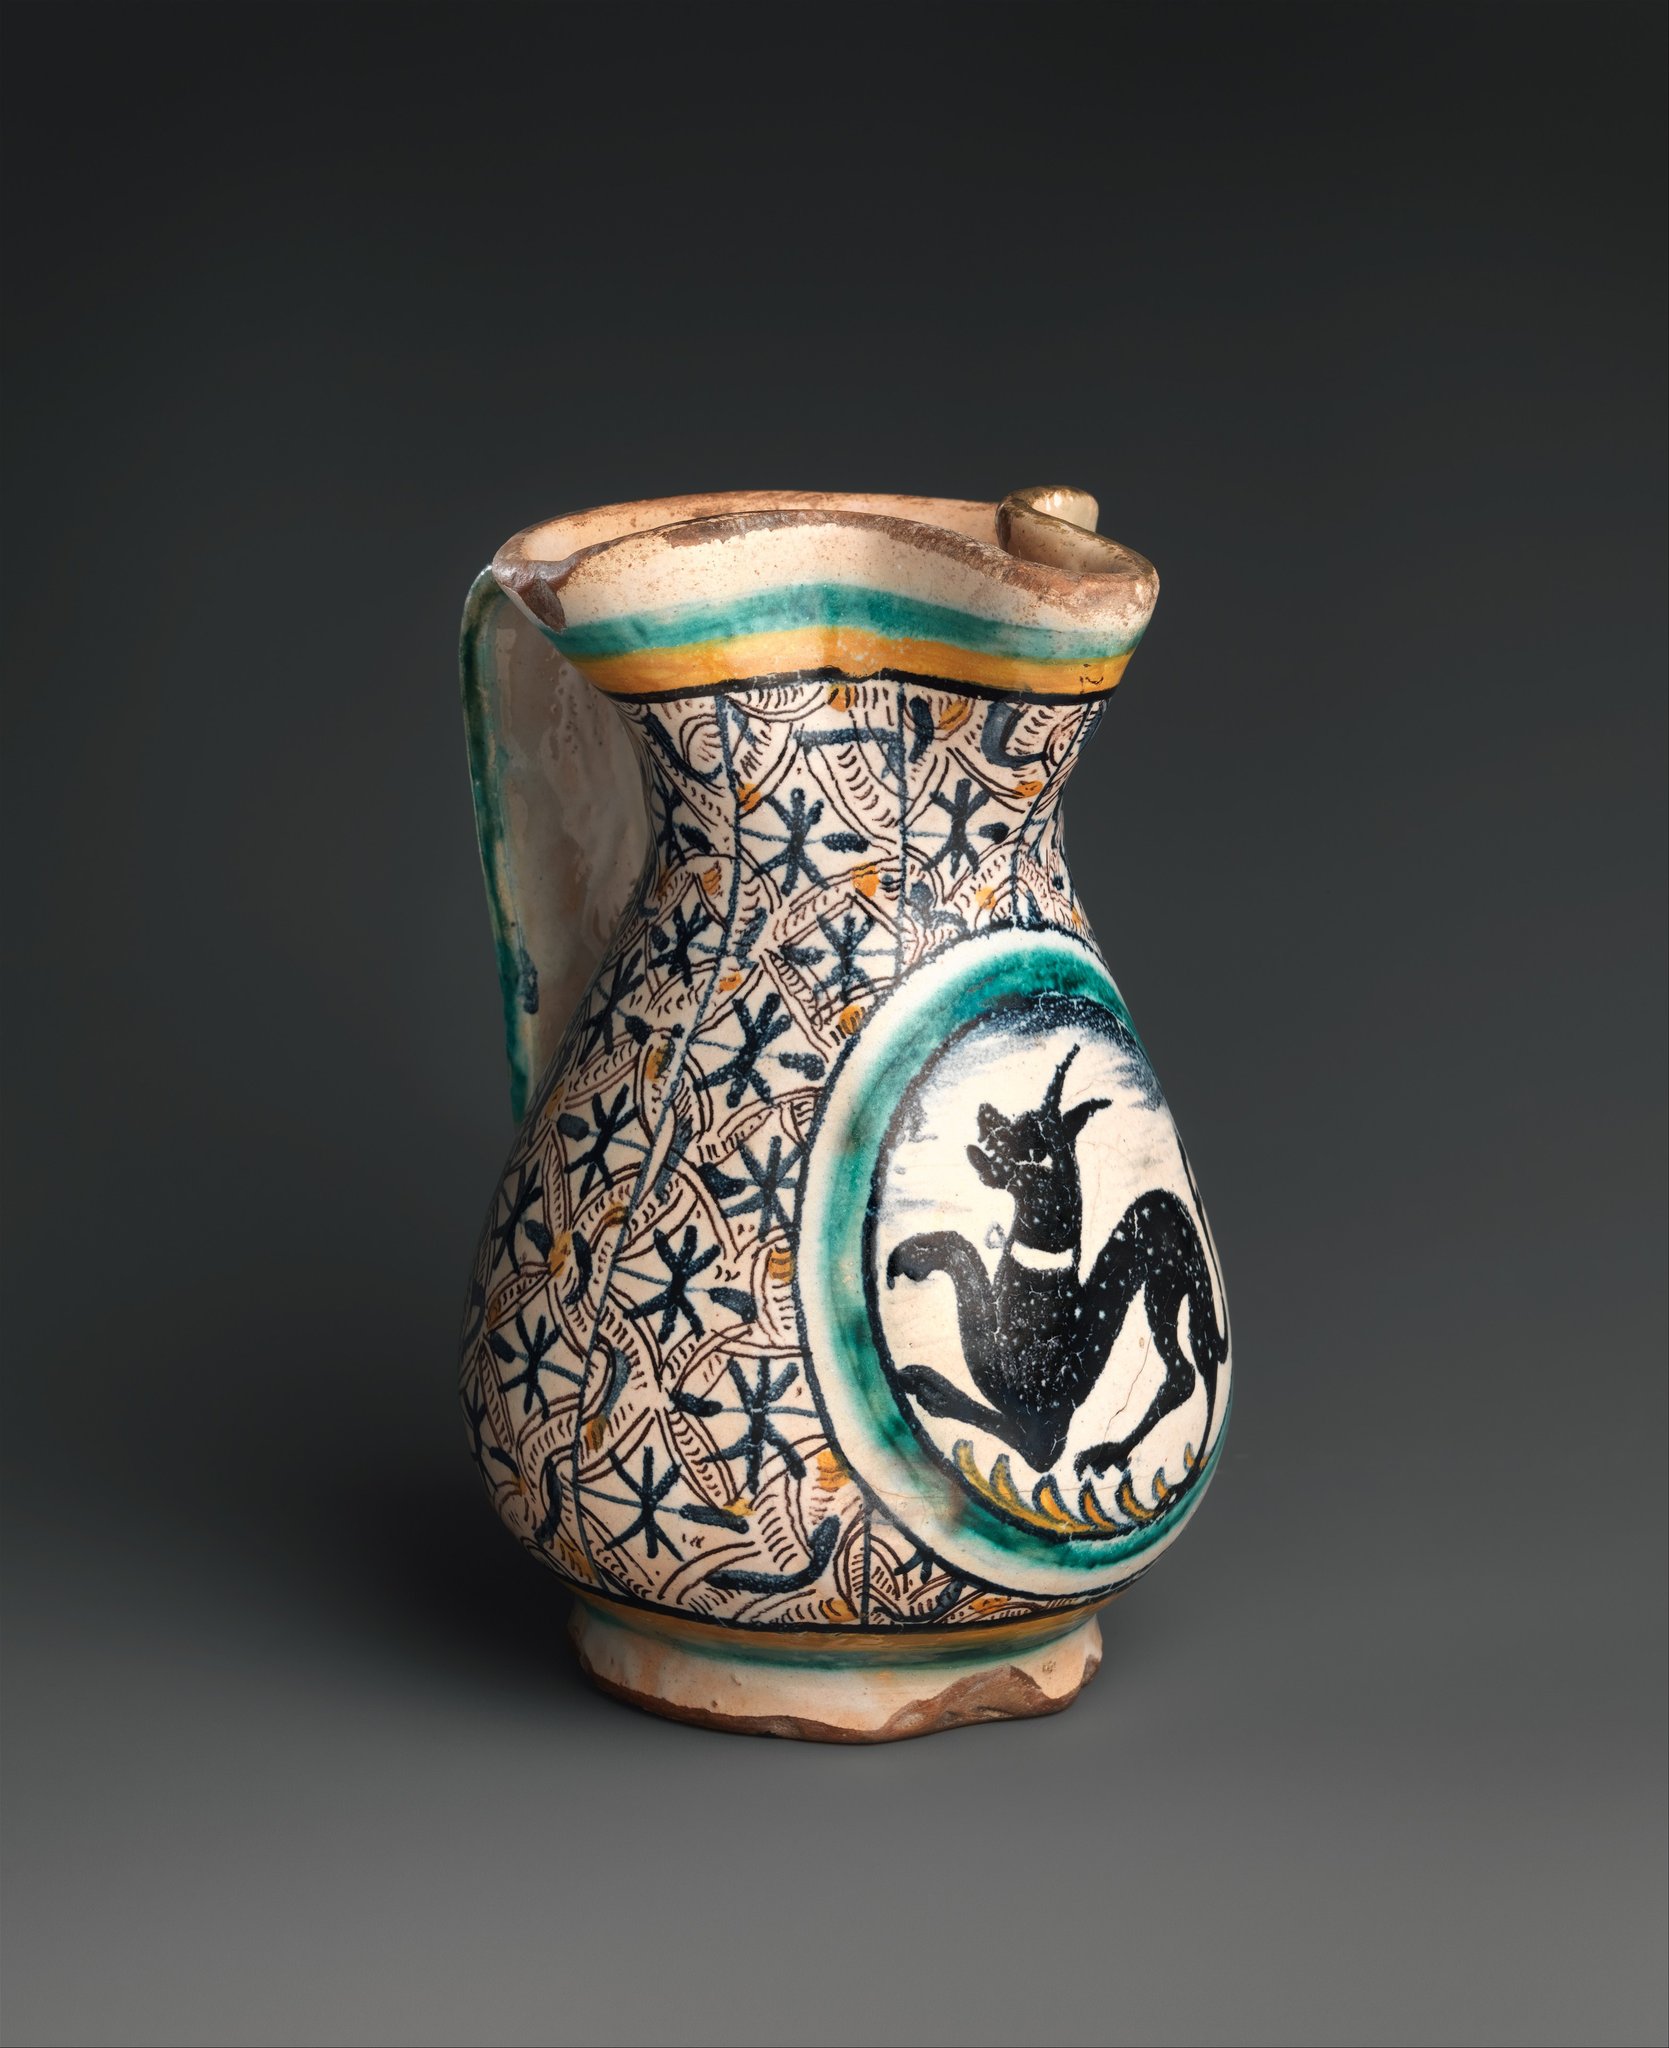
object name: jug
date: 1480-1500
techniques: maiolica, glazing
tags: animals